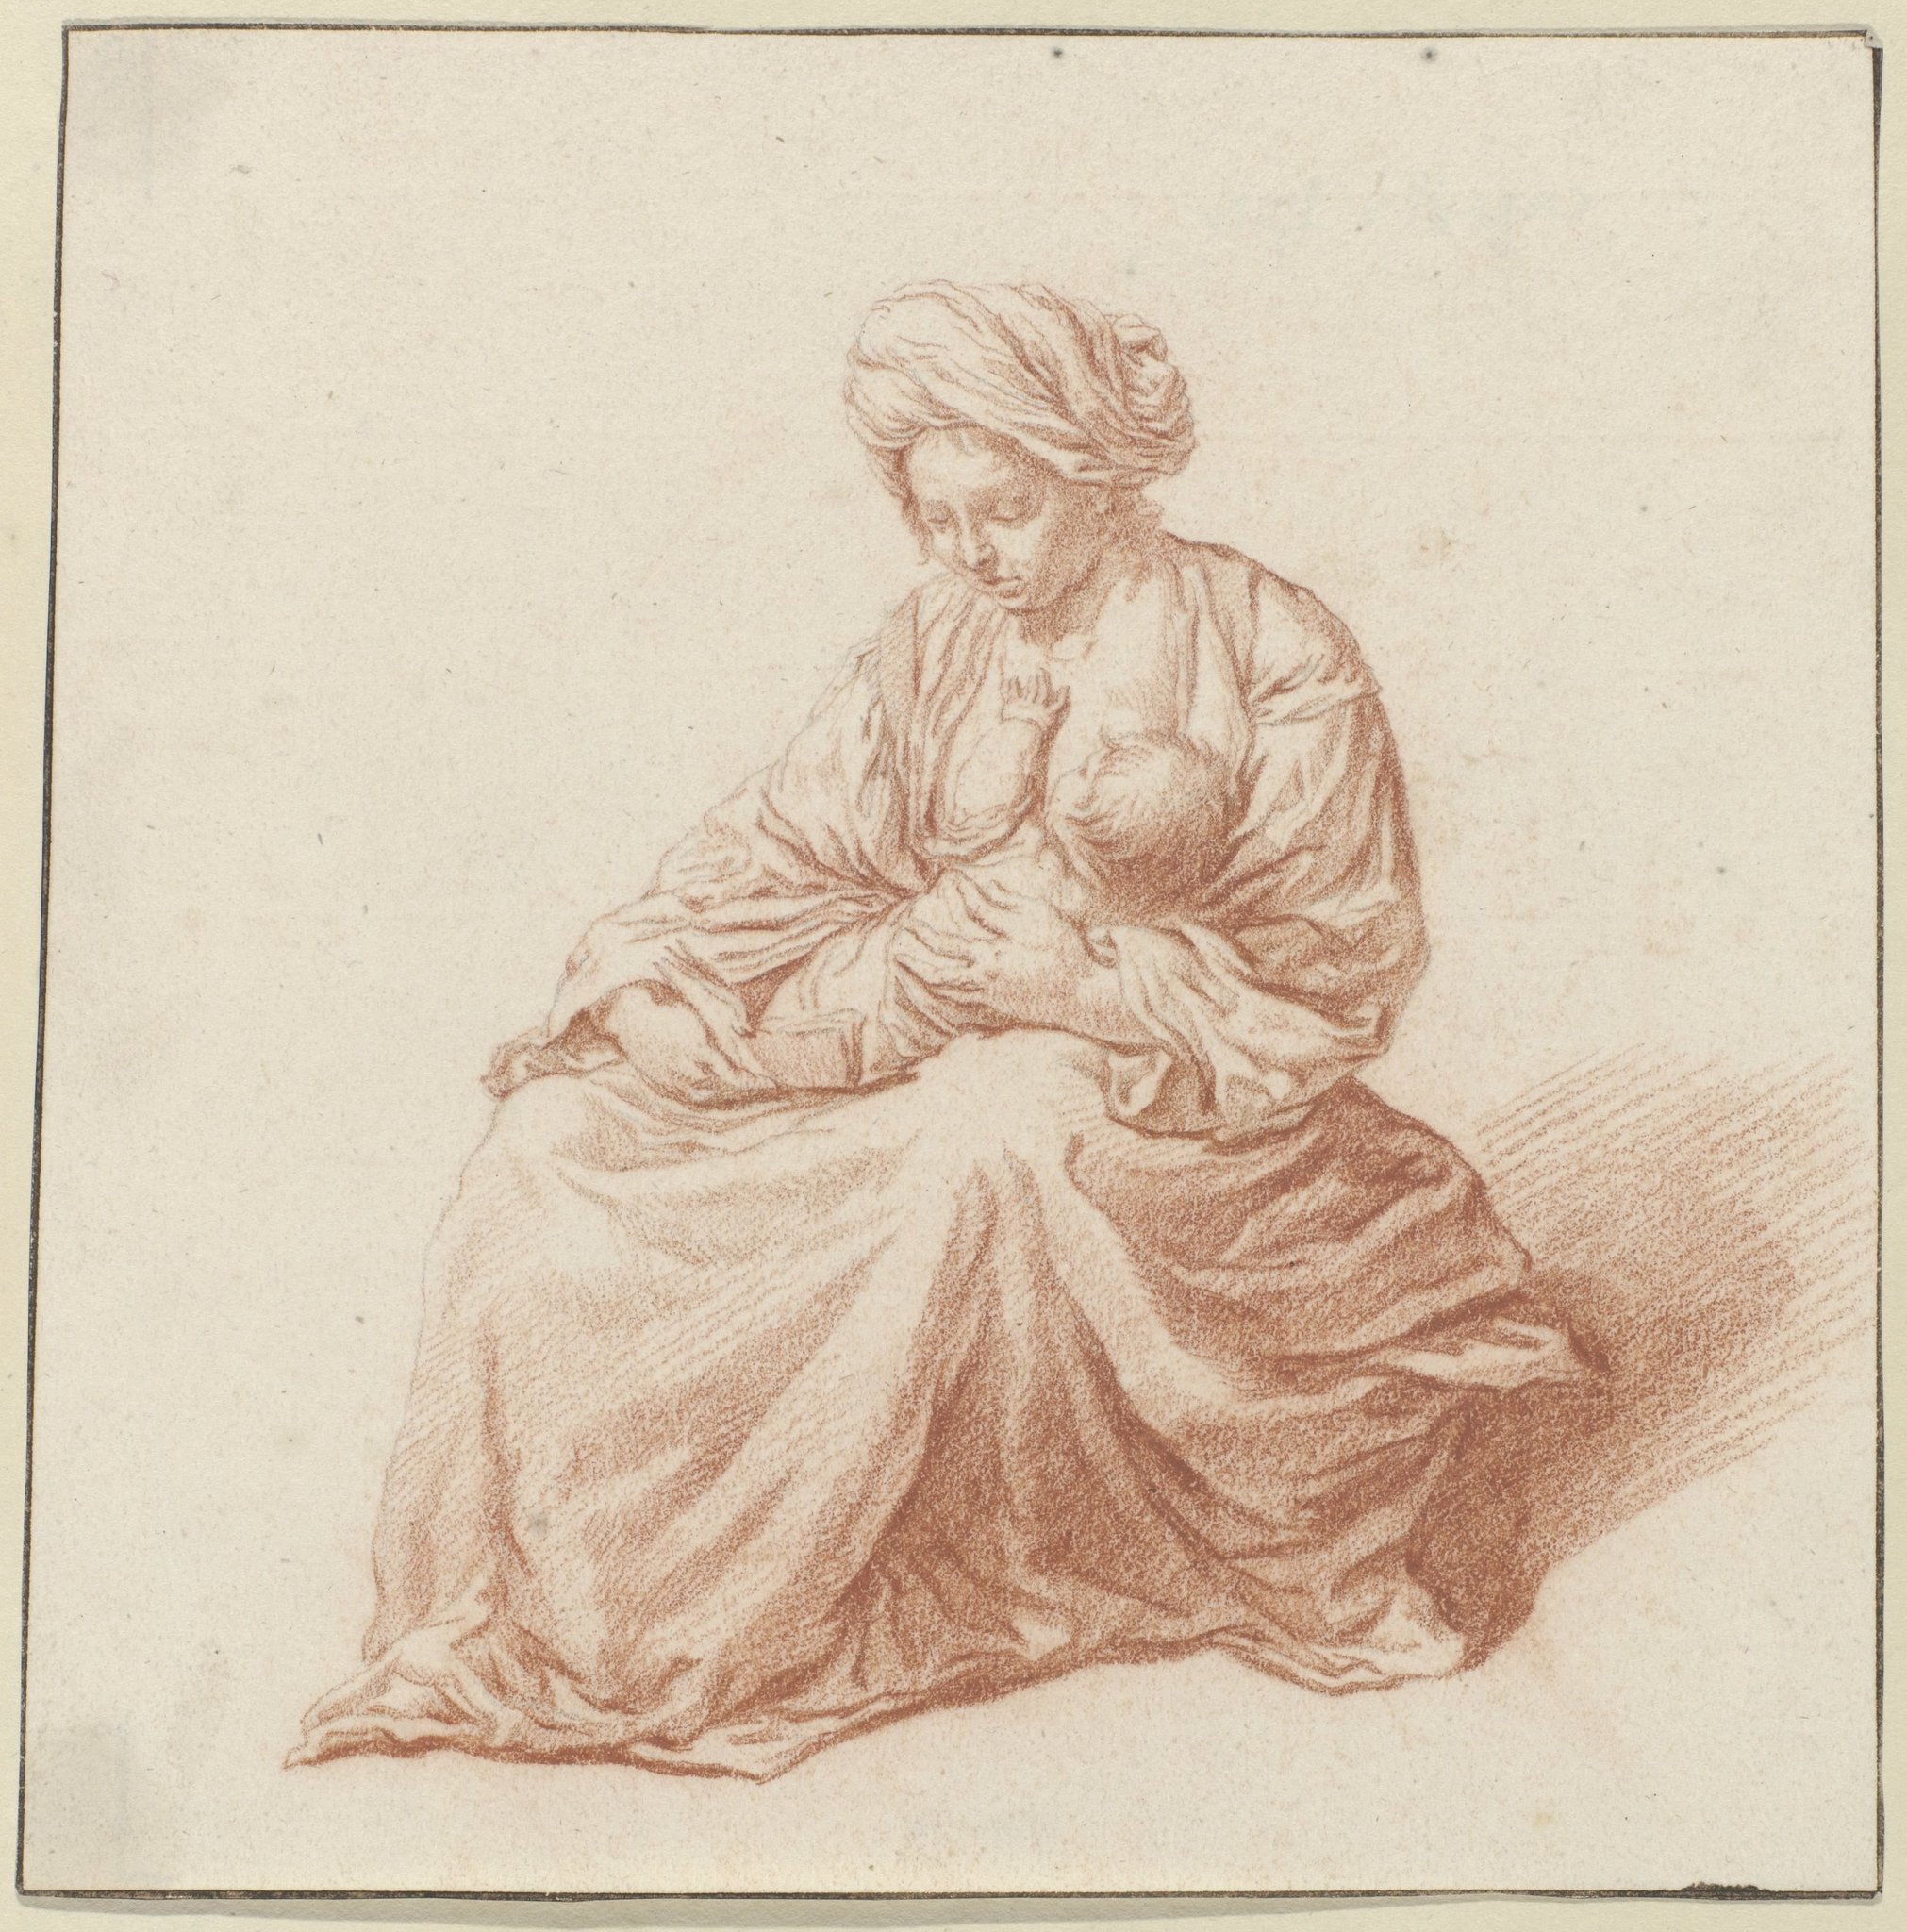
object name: drawing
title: Zittende vrouw met kind aan haar borst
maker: Anonymous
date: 1650-1699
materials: chalk, paper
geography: netherlands